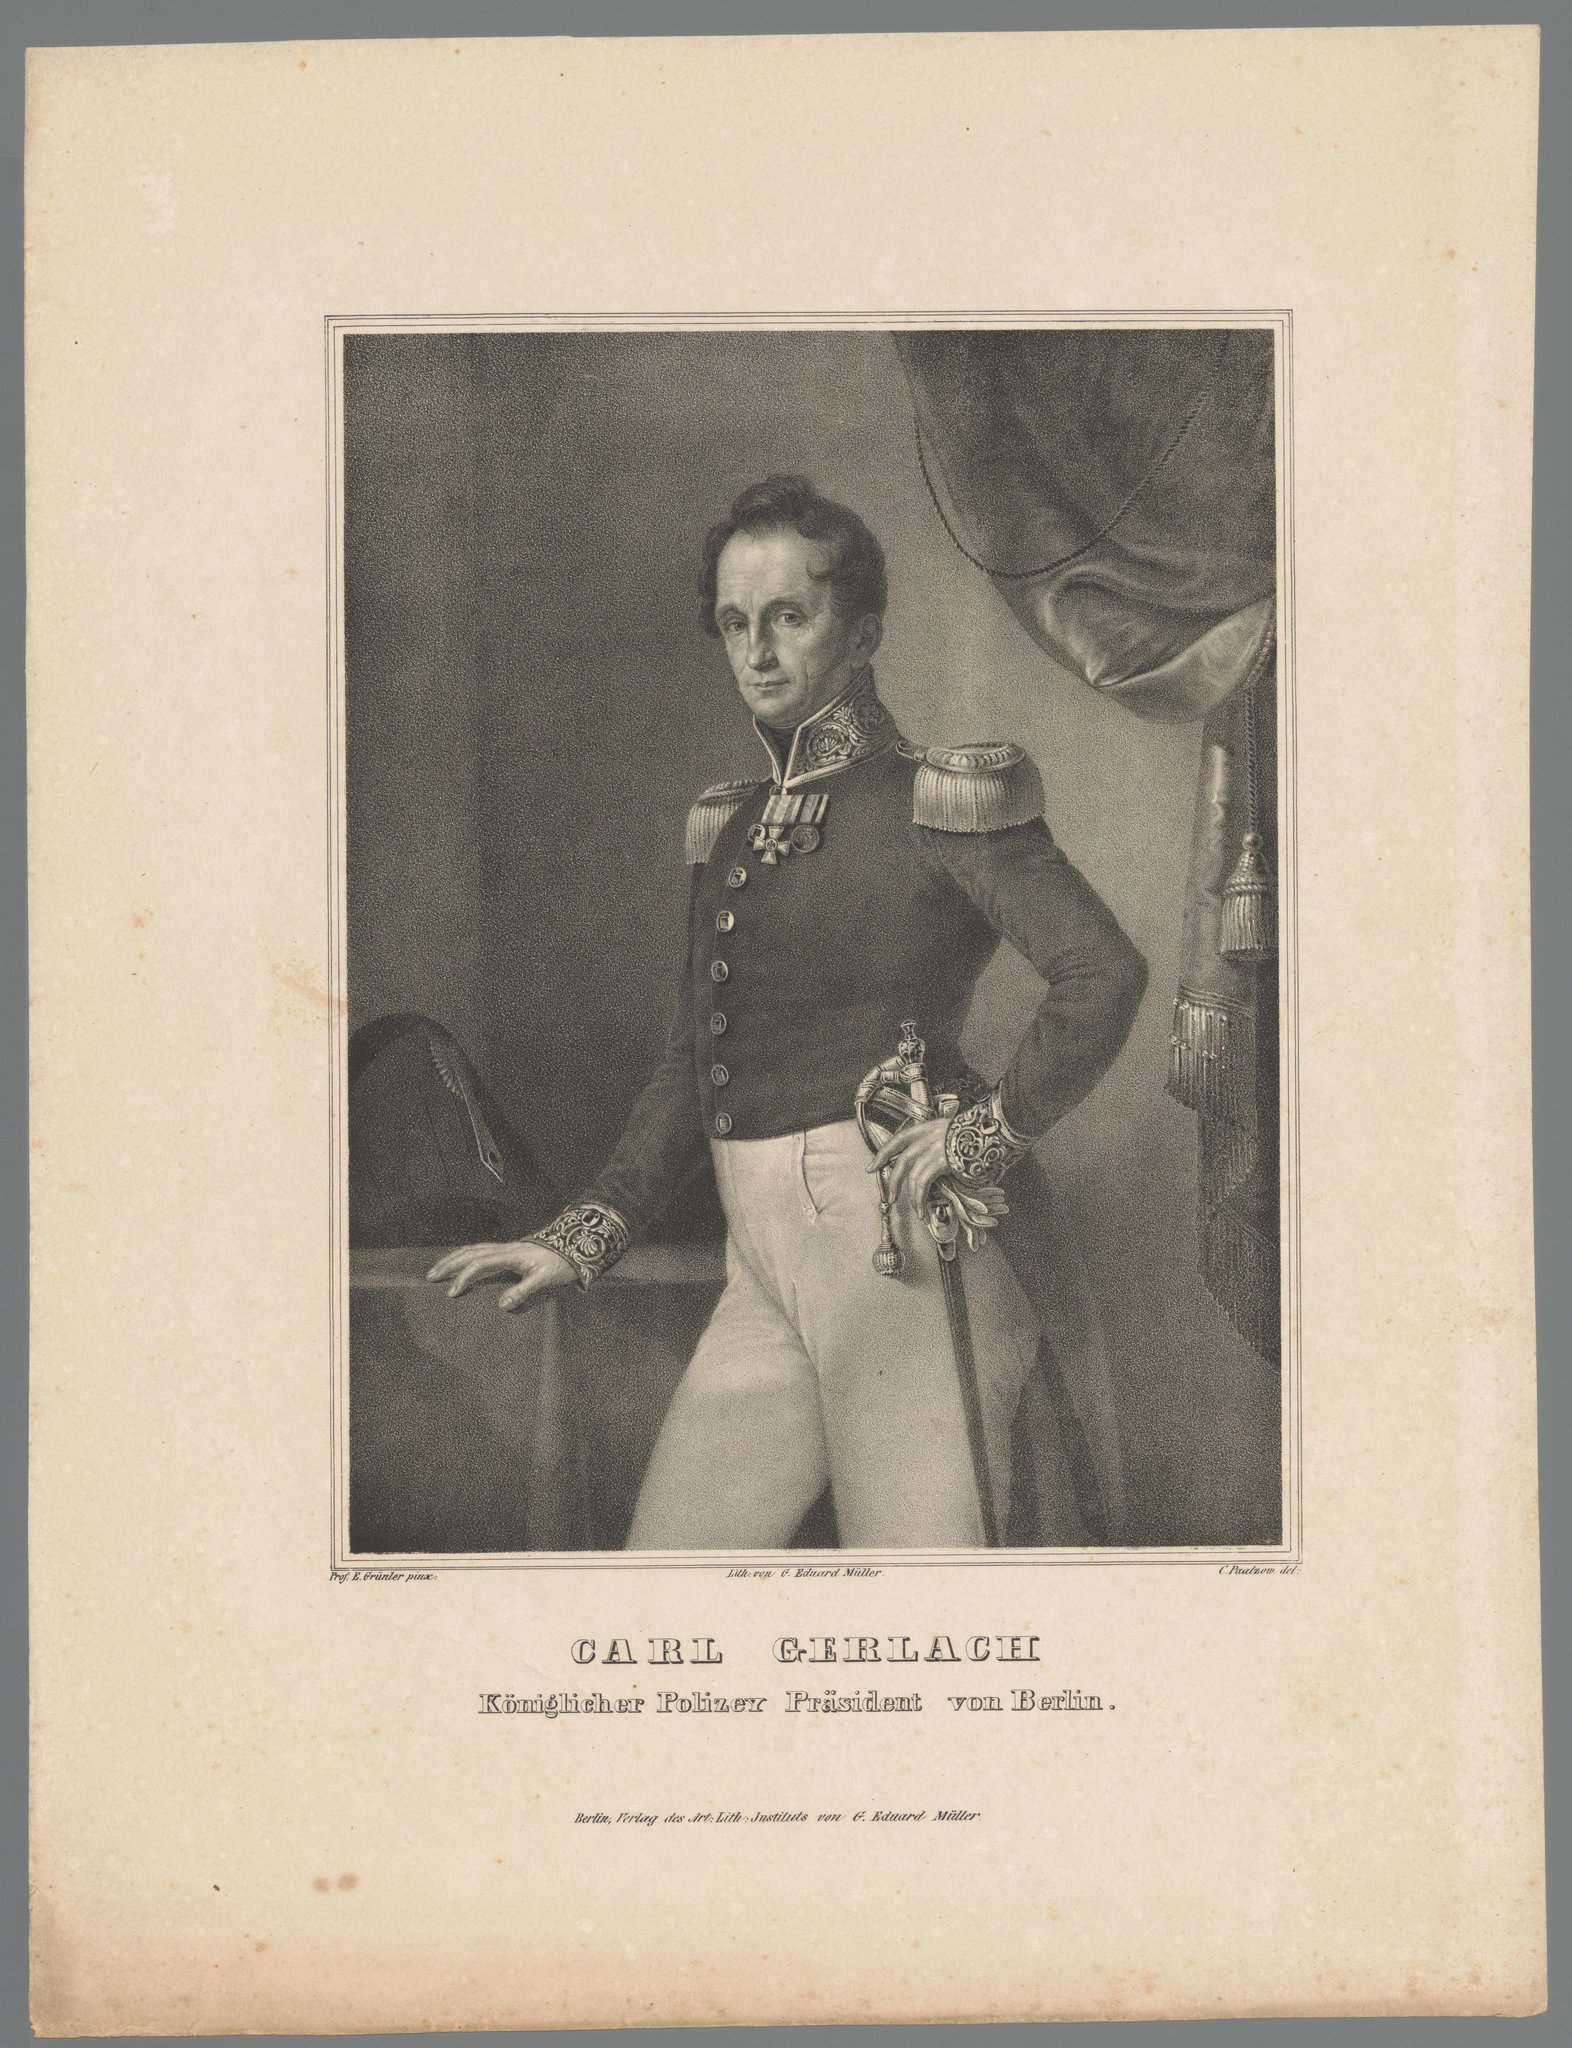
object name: print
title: Portret van Karl Johann Heinrich Eduard von Gerlach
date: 1820-1850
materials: paper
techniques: lithograph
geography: berlin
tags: adult man, historical persons, hacking and thrusting weapons: sword, (military) uniforms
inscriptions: collector's mark: Lugt 2228